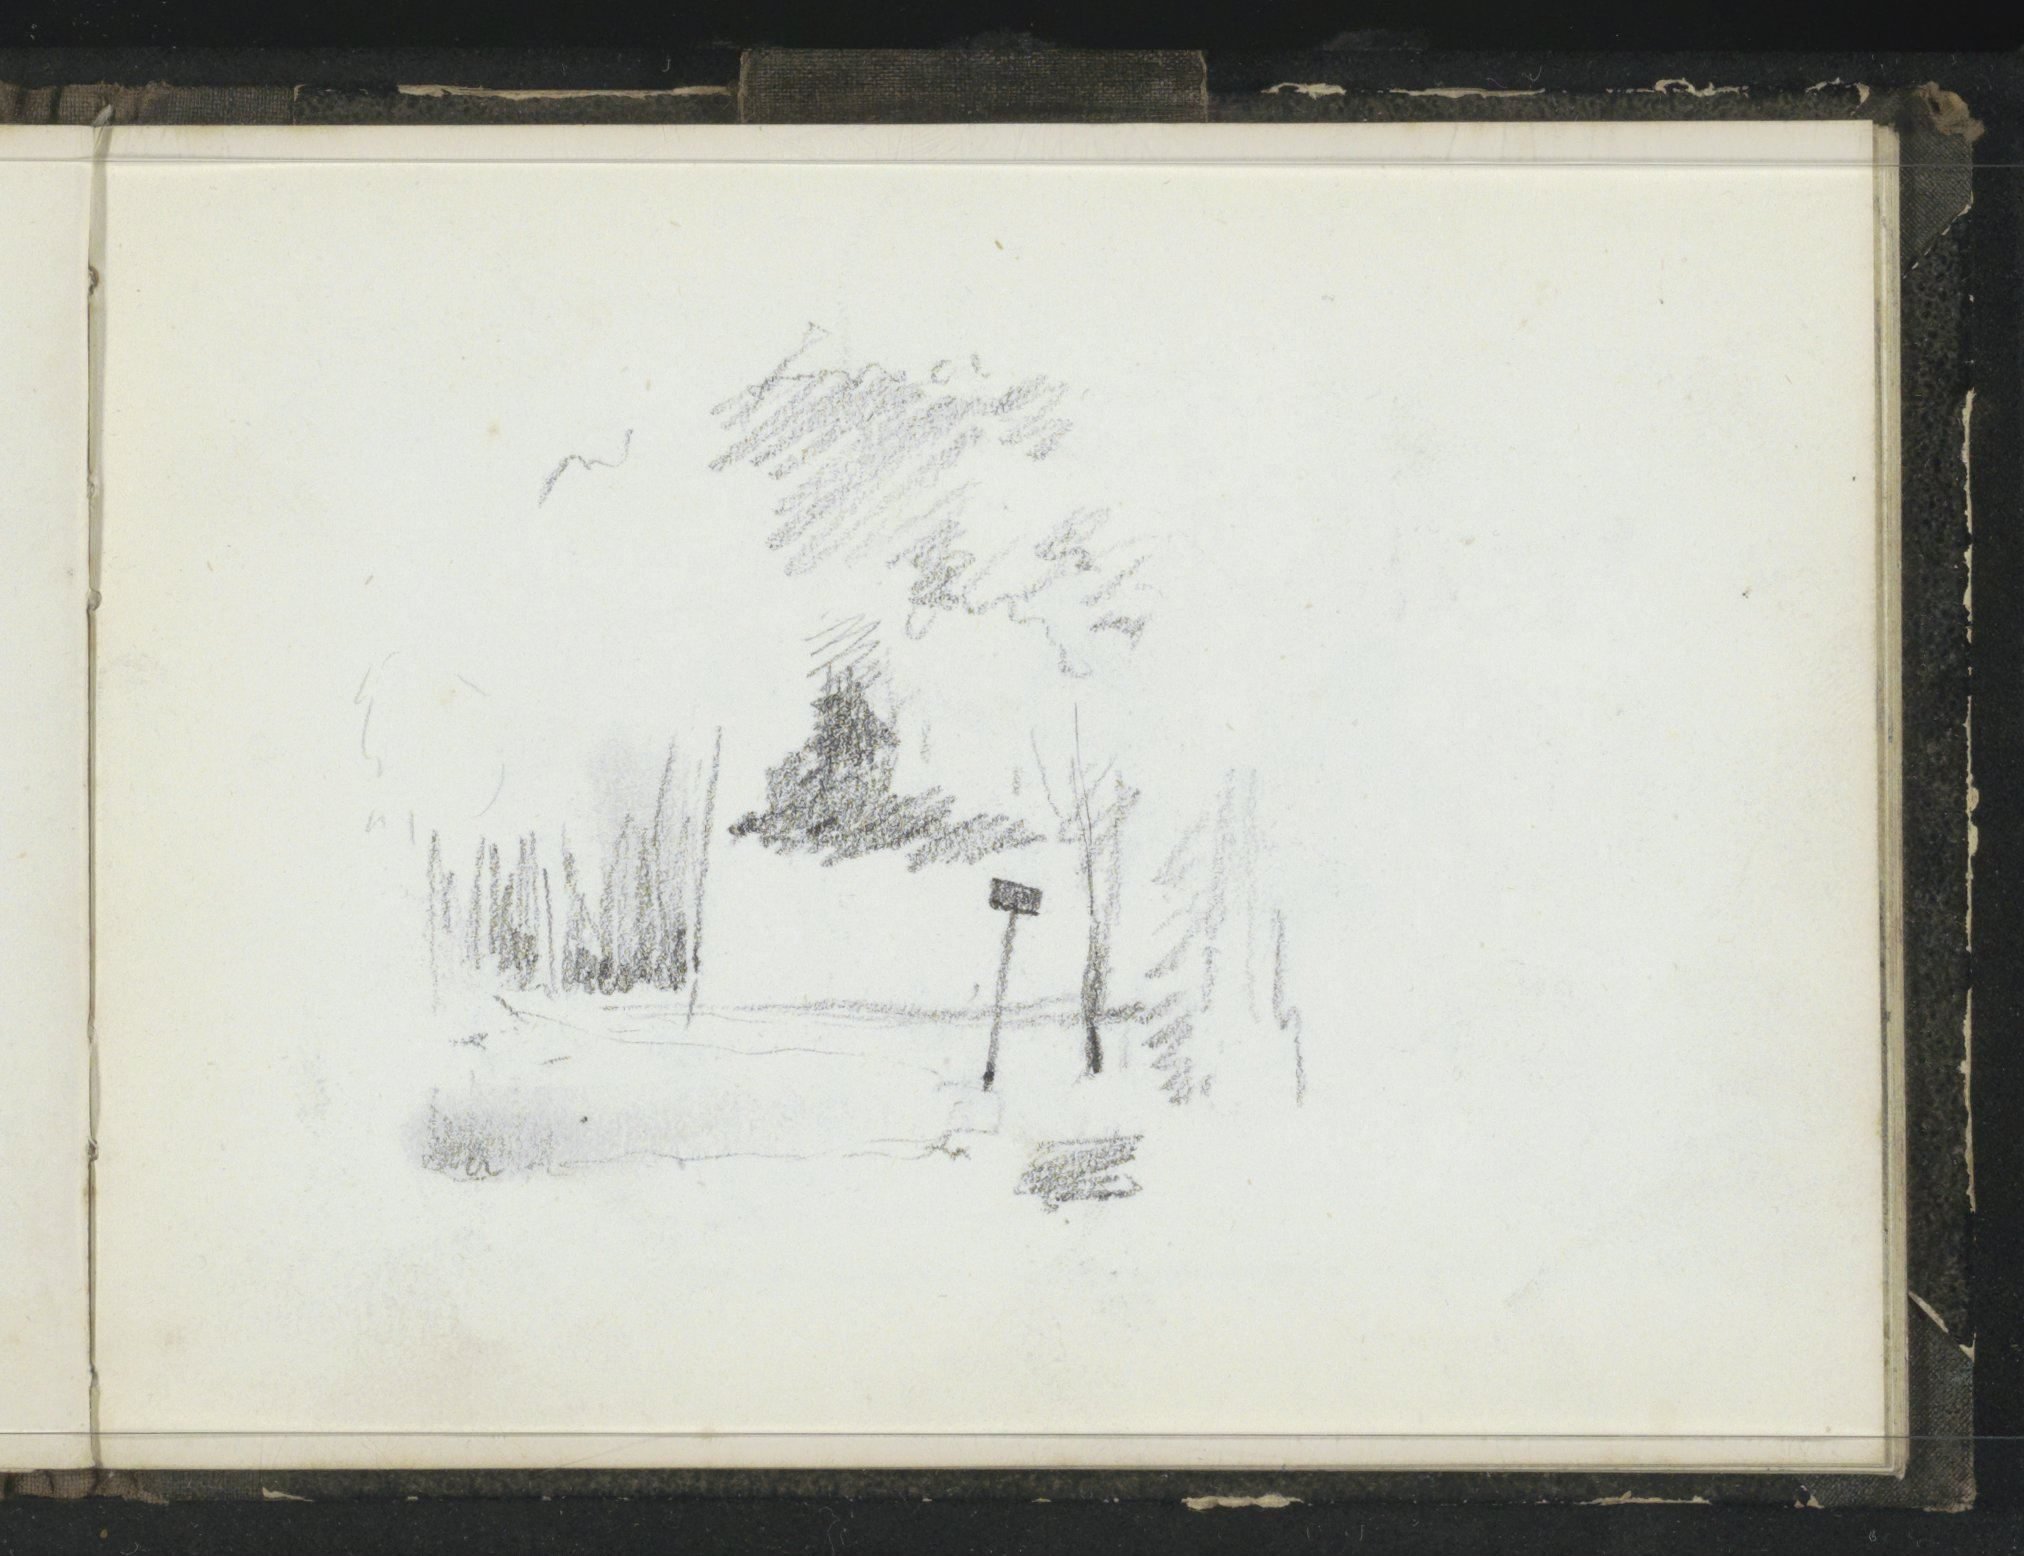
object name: sketchbook leaf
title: Paal aan een waterkant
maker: theo hanrath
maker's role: draughtsman, painter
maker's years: 1853-1883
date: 1879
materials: paper, pencil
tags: landscapes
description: Blad 15 recto uit een schetsboek met 27 bladen.